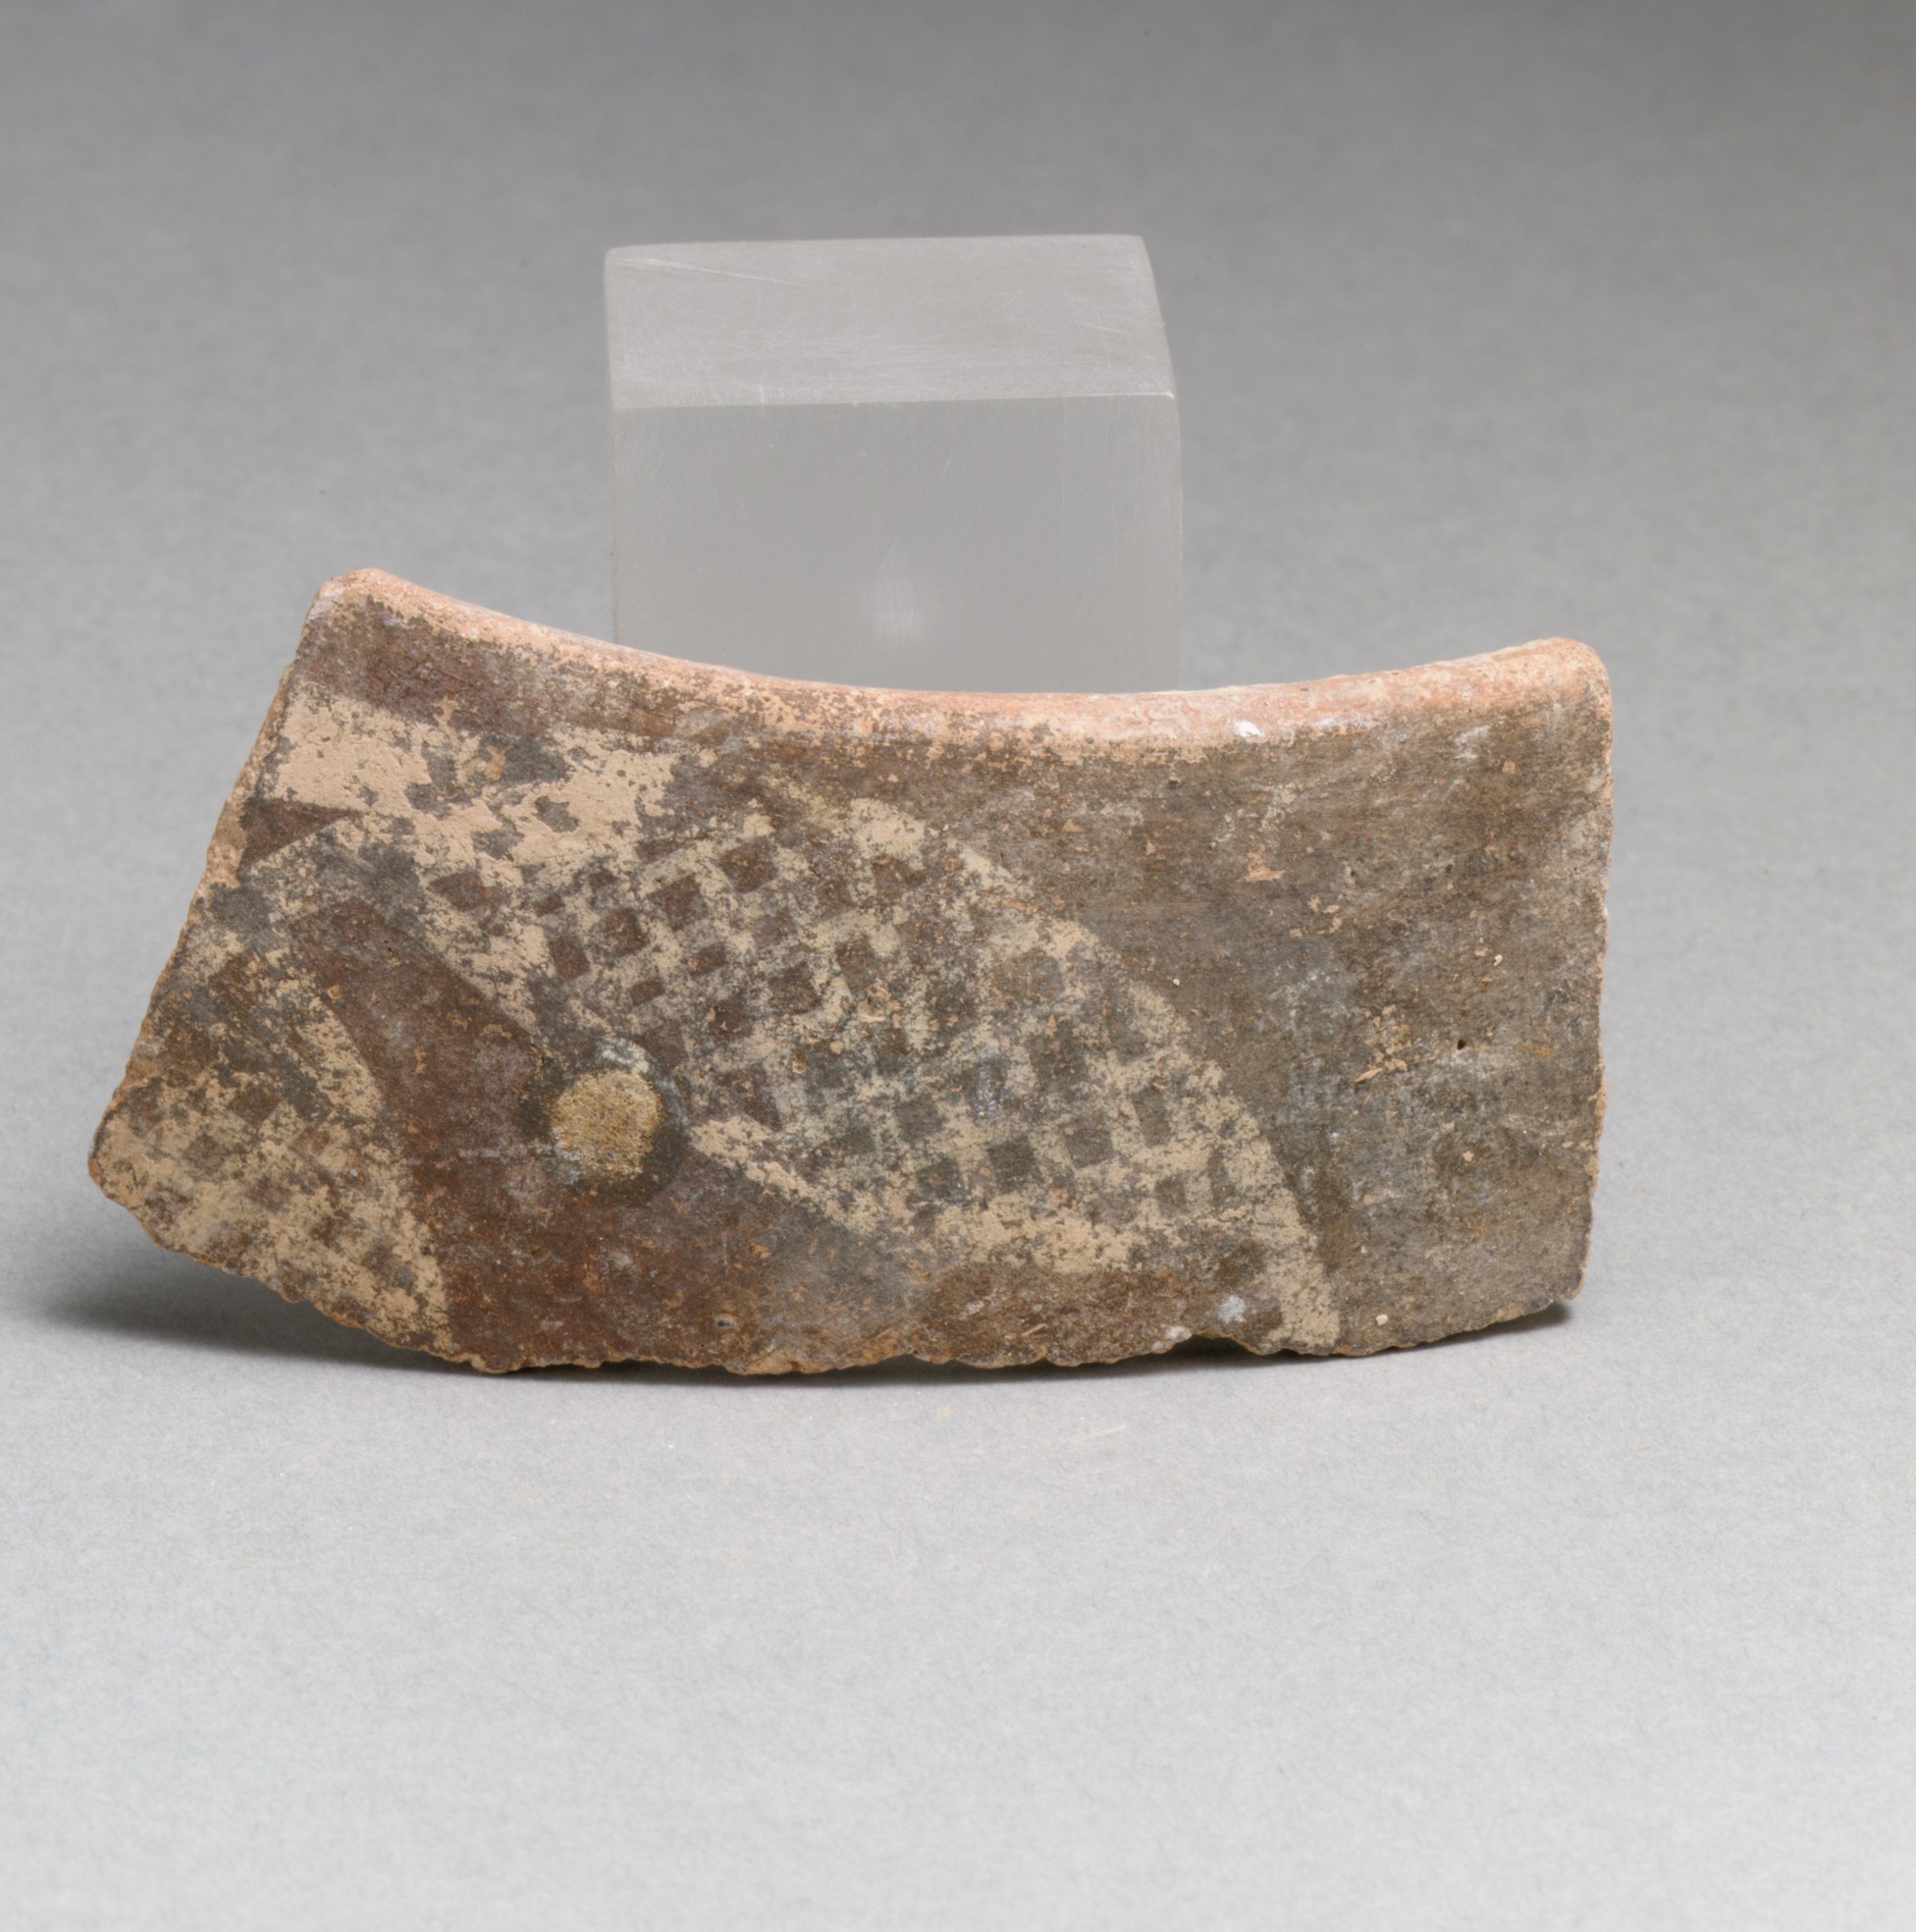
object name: vase fragment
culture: minoan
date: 2600-2000 BCE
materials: terracotta